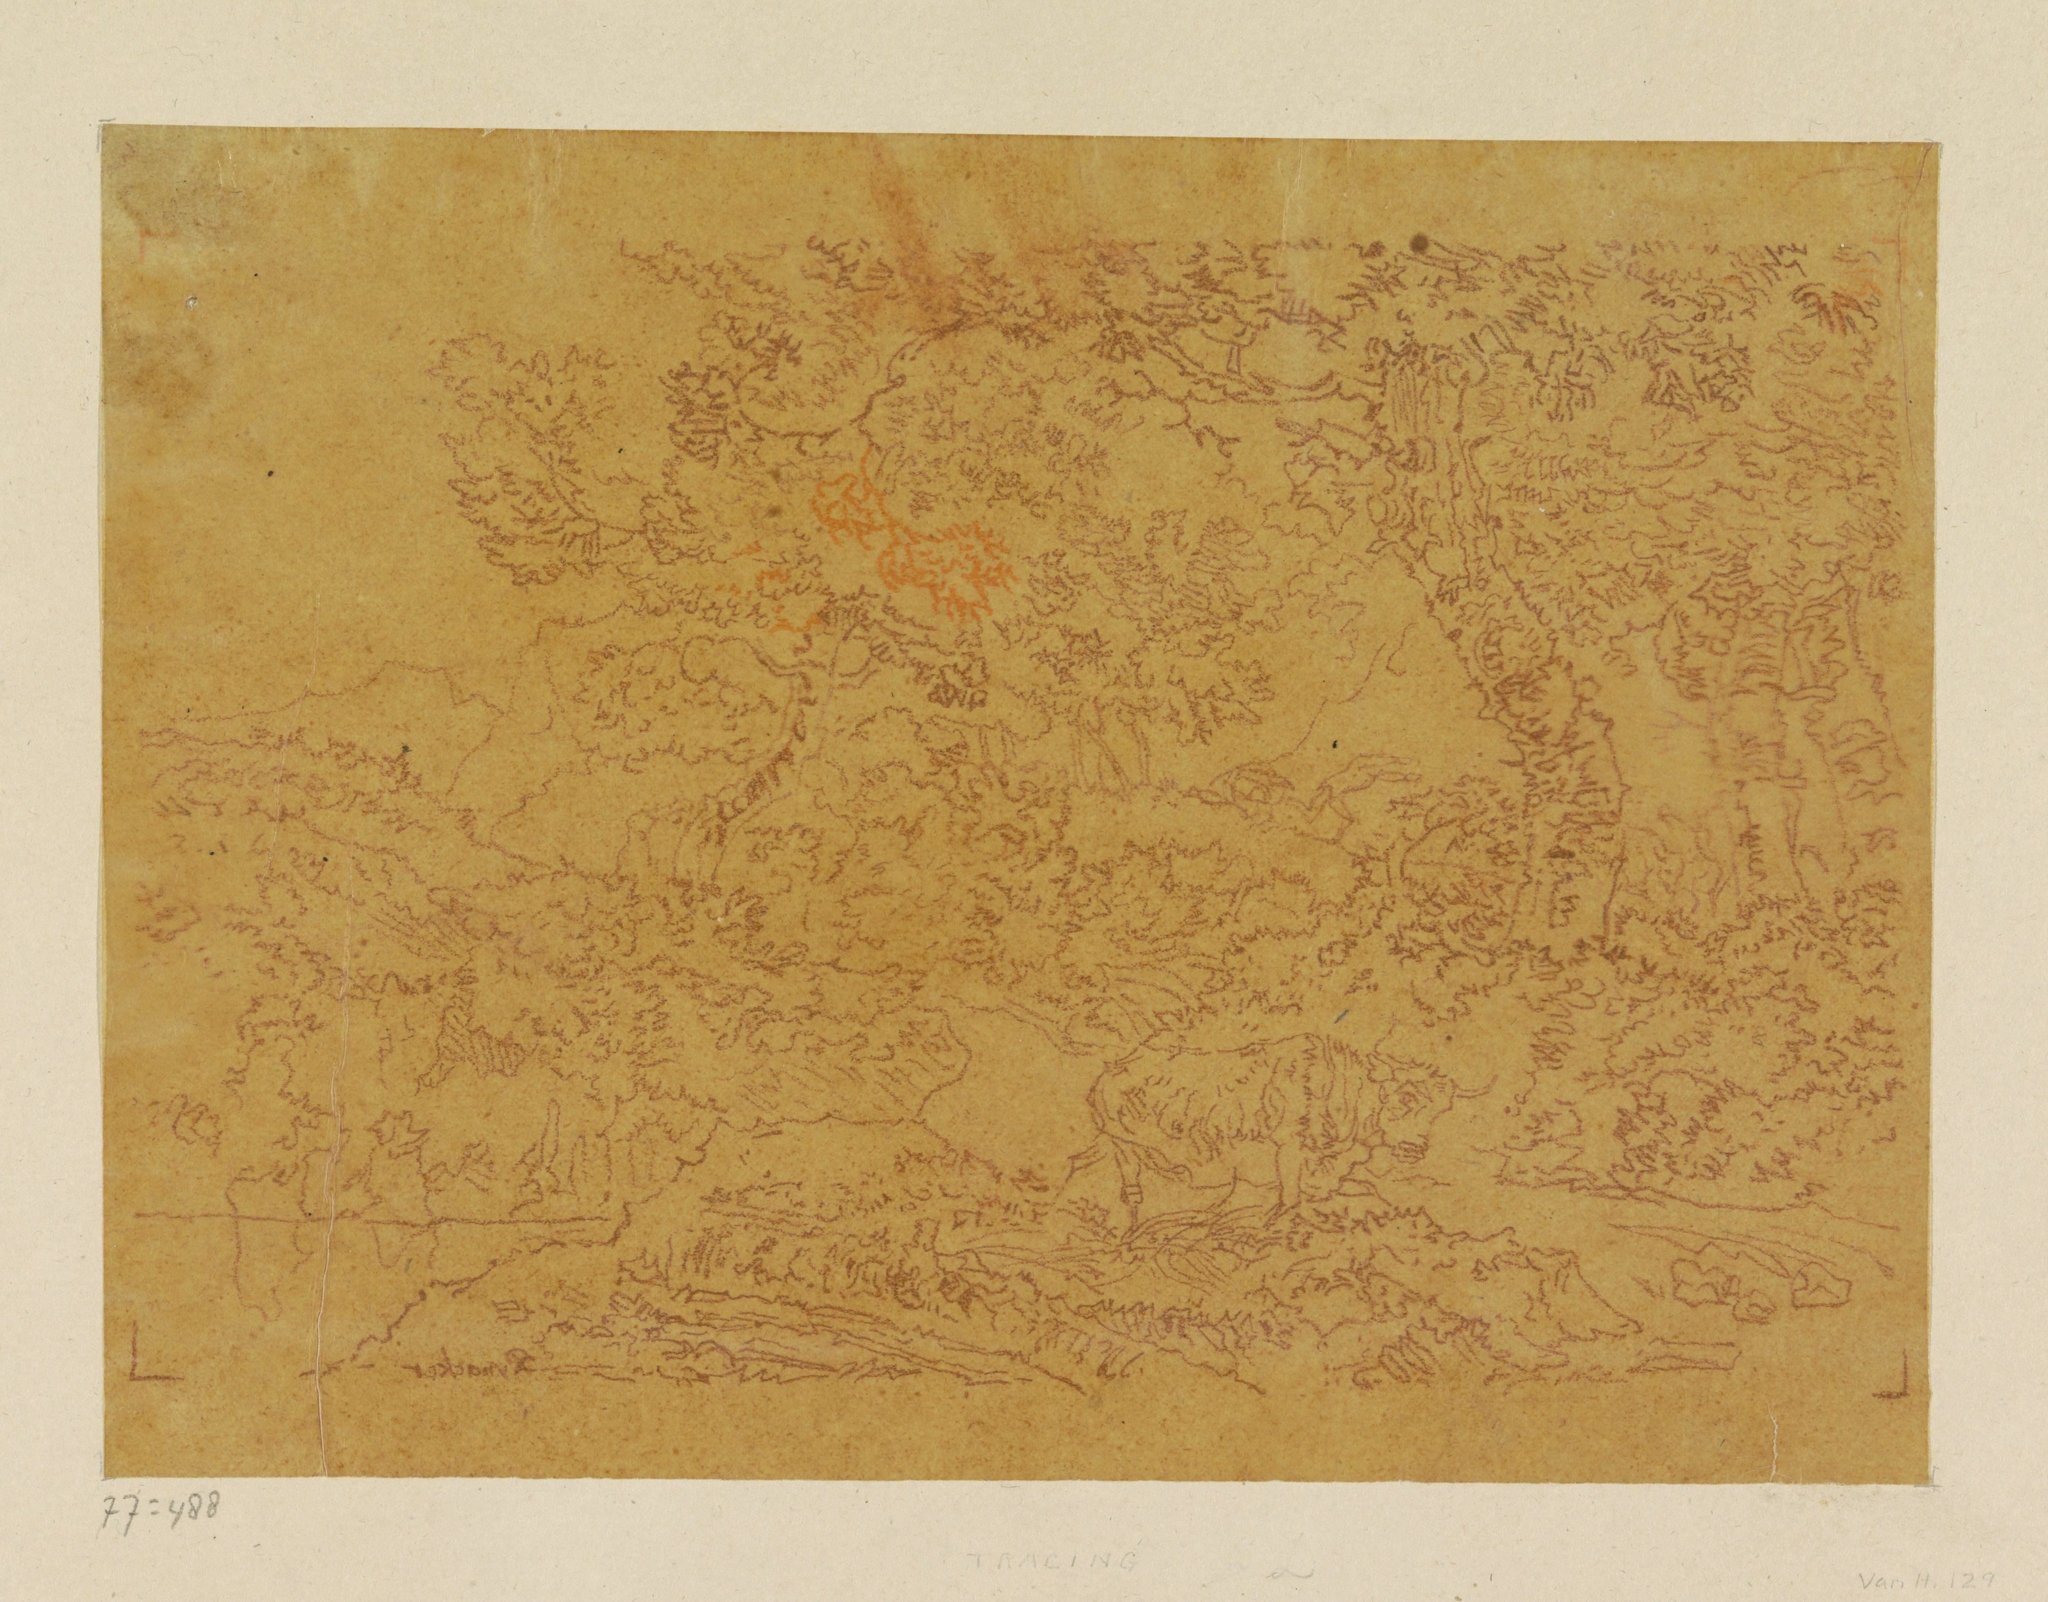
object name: tracing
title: Boslandschap met stier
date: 1795-1821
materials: chalk, paper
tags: bull, landscapes (+ landscape with figures, staffage)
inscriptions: collector's mark: Lugt 2228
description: De prent werd opgenomen in: Collection d'imitations de dessins d'après les principaux maîtres hollandais et flamands, Londen, C. Josi, 1821.